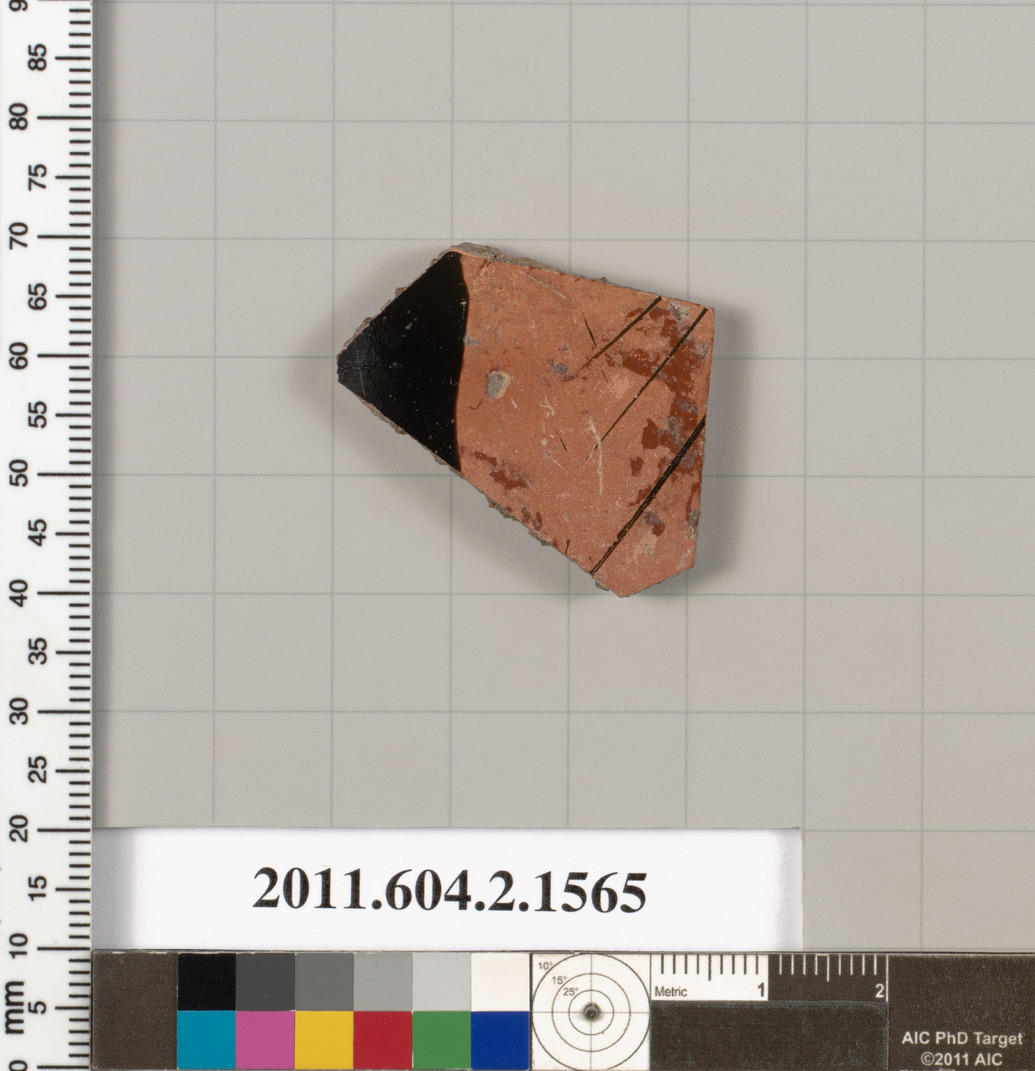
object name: skyphos fragment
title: Terracotta fragment of a skyphos (deep drinking cup)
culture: greek, attic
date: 450-426 BCE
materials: terracotta